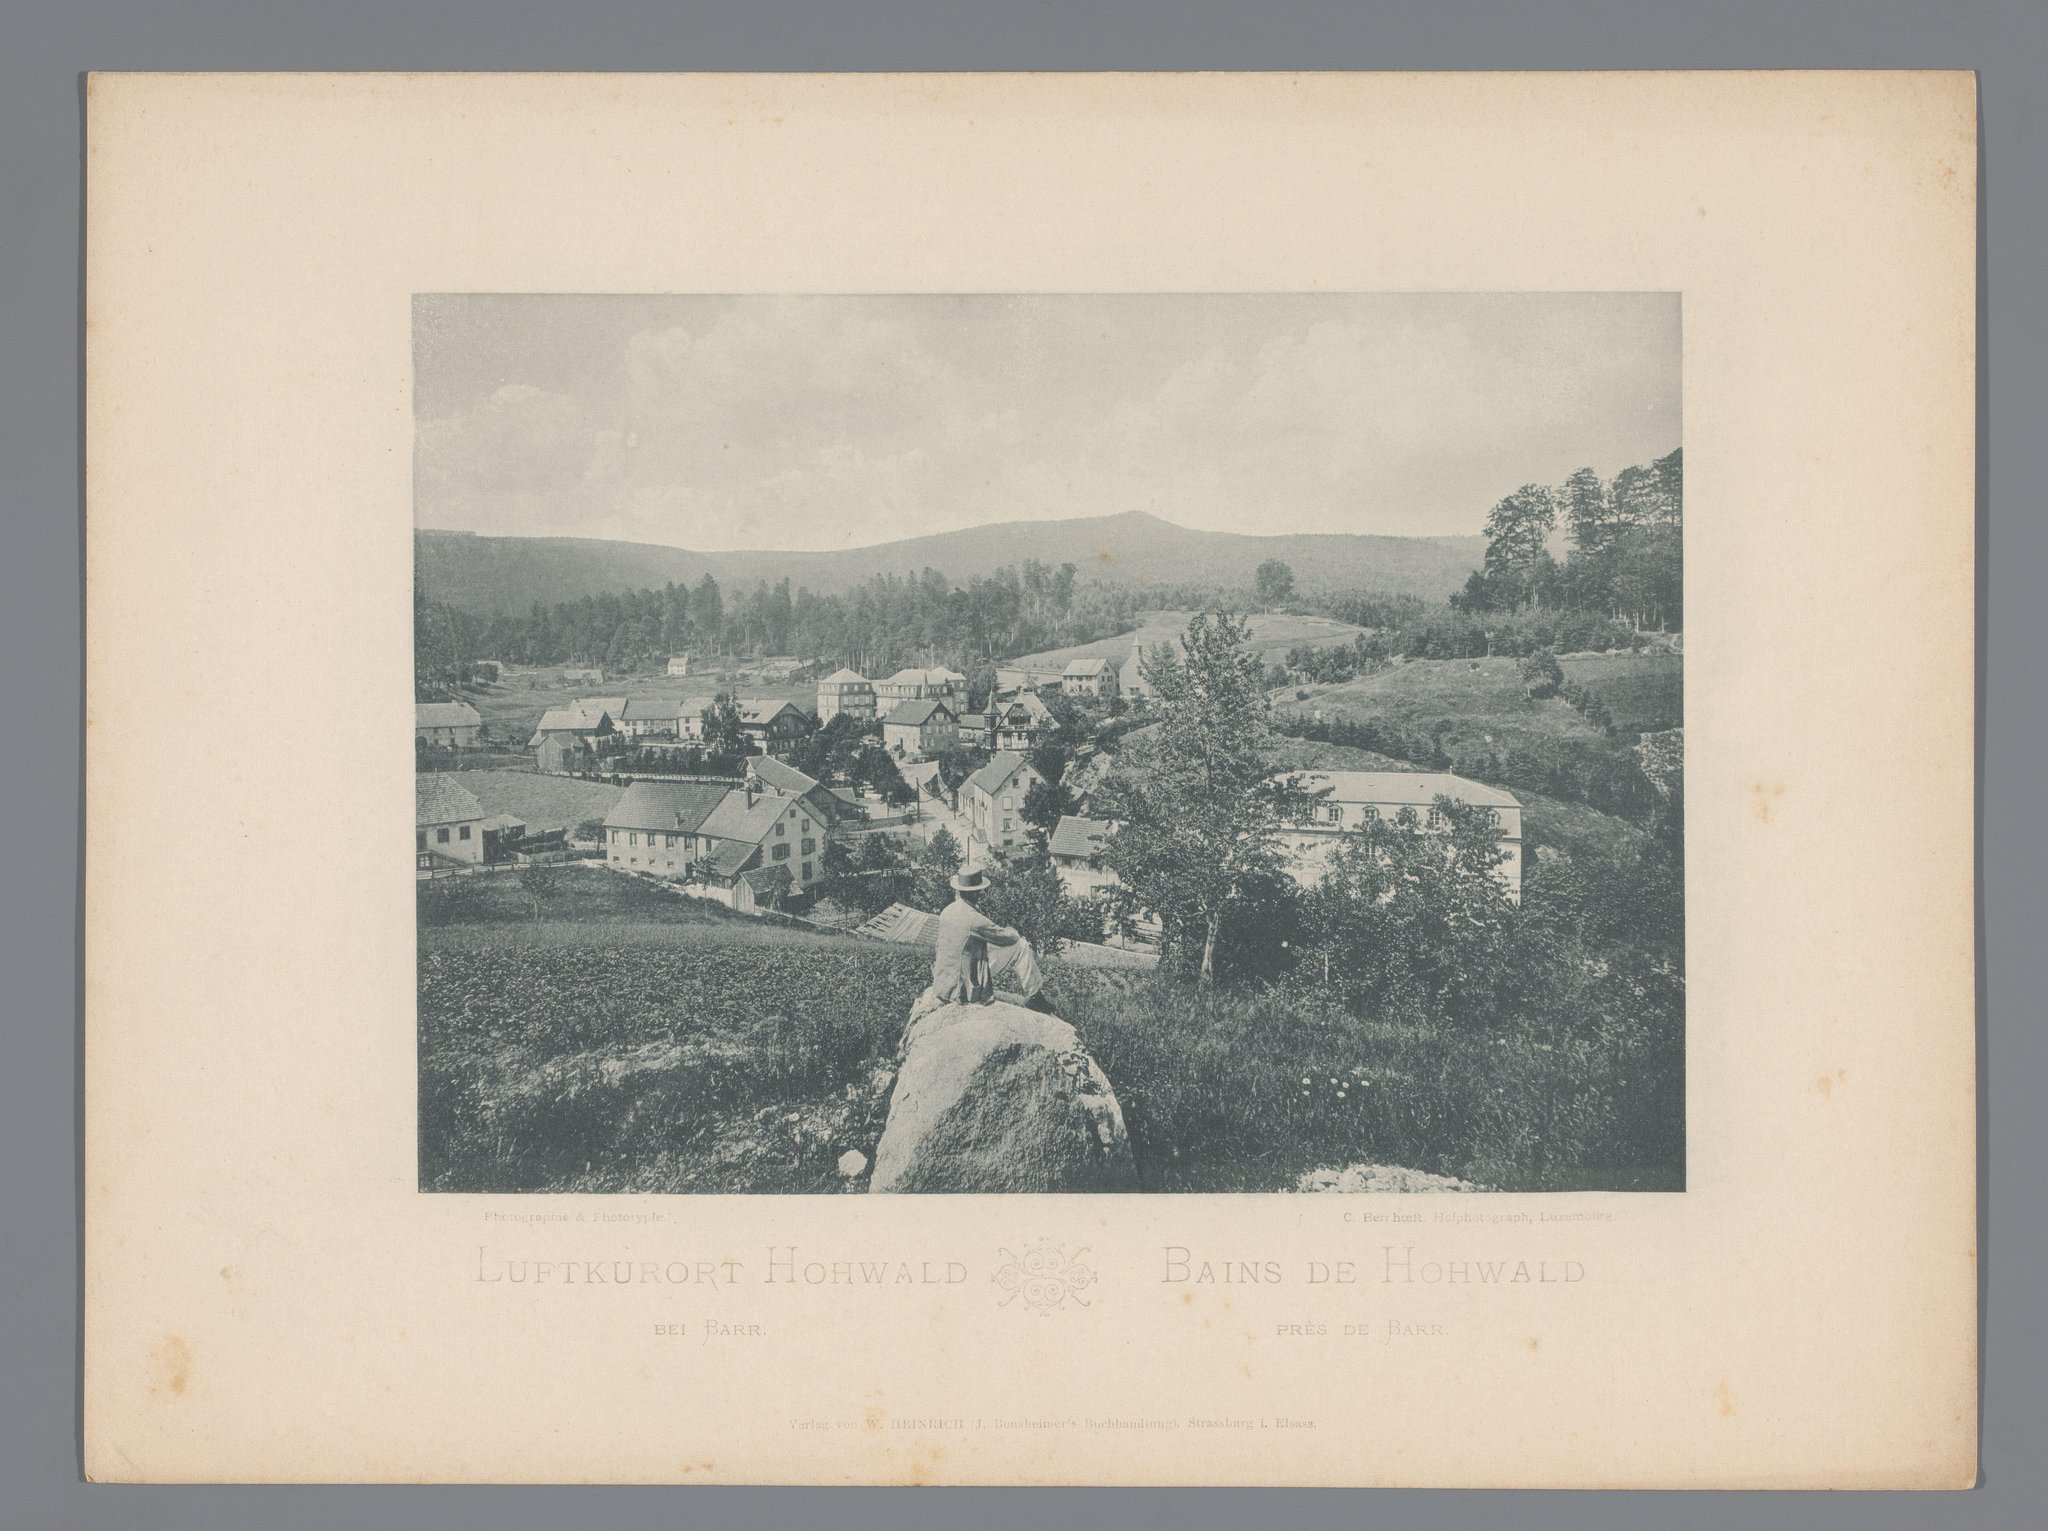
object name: page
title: Luftkurort Hohwald, Bains de Hohwald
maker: charles bernhoeft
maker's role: publisher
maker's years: 1859-1933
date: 1889-1894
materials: paper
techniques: photograph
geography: straatsburg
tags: watering-place, spa, village (+ city(-scape) with figures, staffage)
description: Deze prent maakt deel uit van een omslag met 100 prenten.